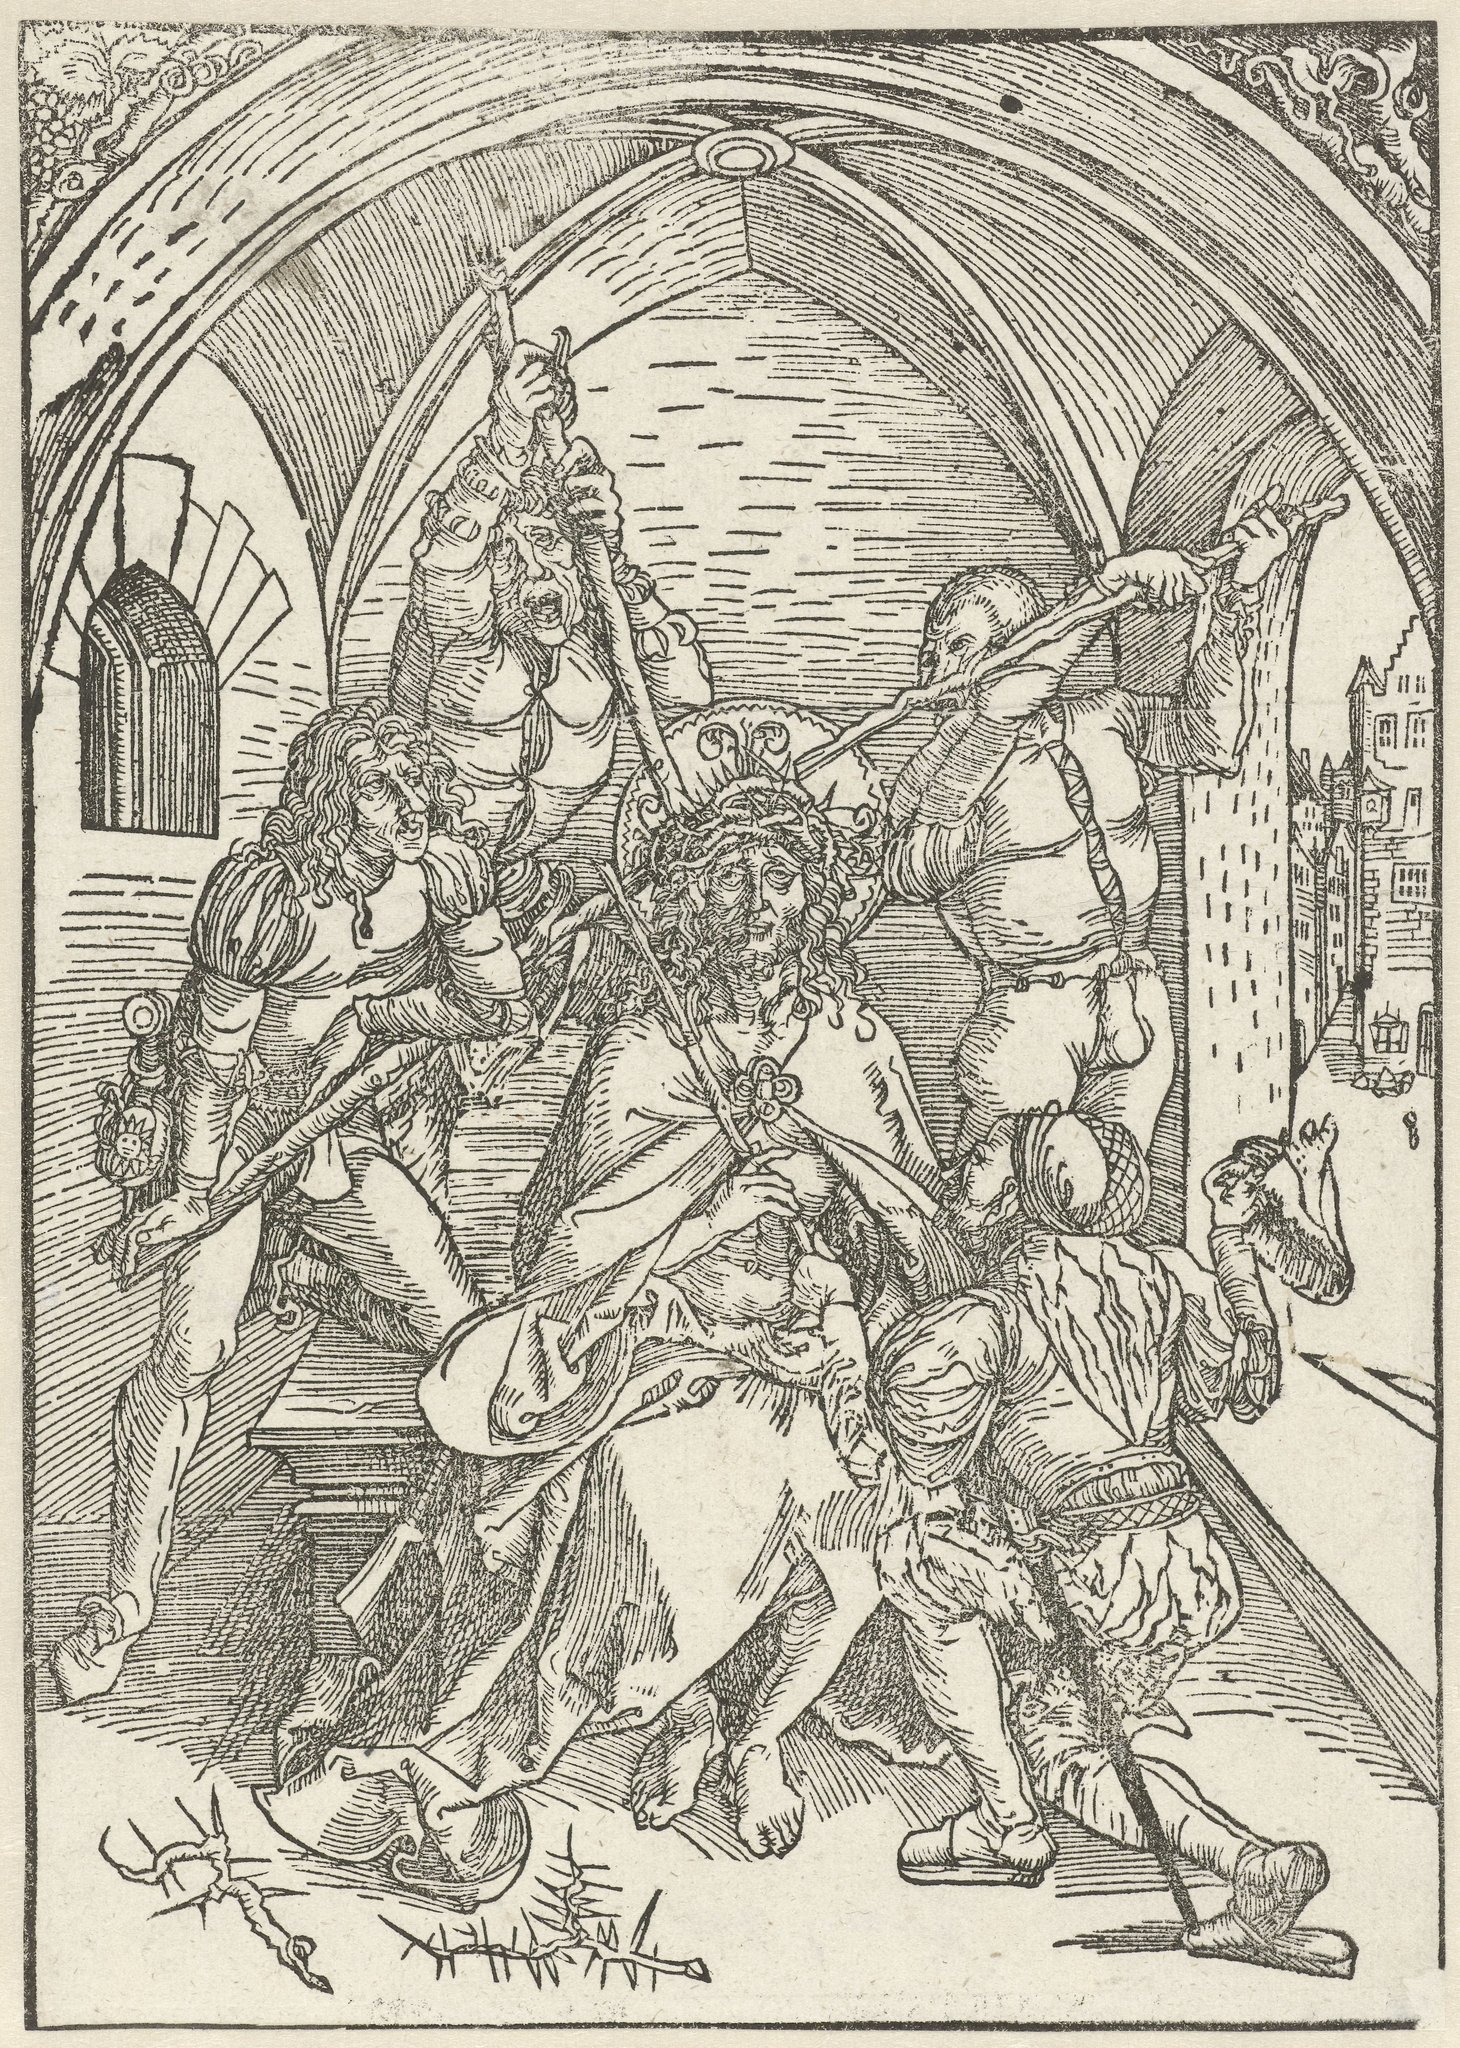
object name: print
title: Albertina Passie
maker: albrecht dürer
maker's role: draughtsman, painter, print maker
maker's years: 1471-1528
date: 1498-1502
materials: paper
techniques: woodcut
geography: nuremberg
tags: the crowning with thorns: soldiers with sticks place a thorny crown on christ's head and give him a reed (matthew 27:27-31; mark 15:16-20; john 19:2-3)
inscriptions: collector's mark: Lugt 2228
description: Christus, zittend op een verhoging, krijgt een doornenkroon op het hoofd geduwd. Deze prent is onderdeel van de zogenoemde 'Albertina Passie', een onvoltooide passiereeks (4 prenten).